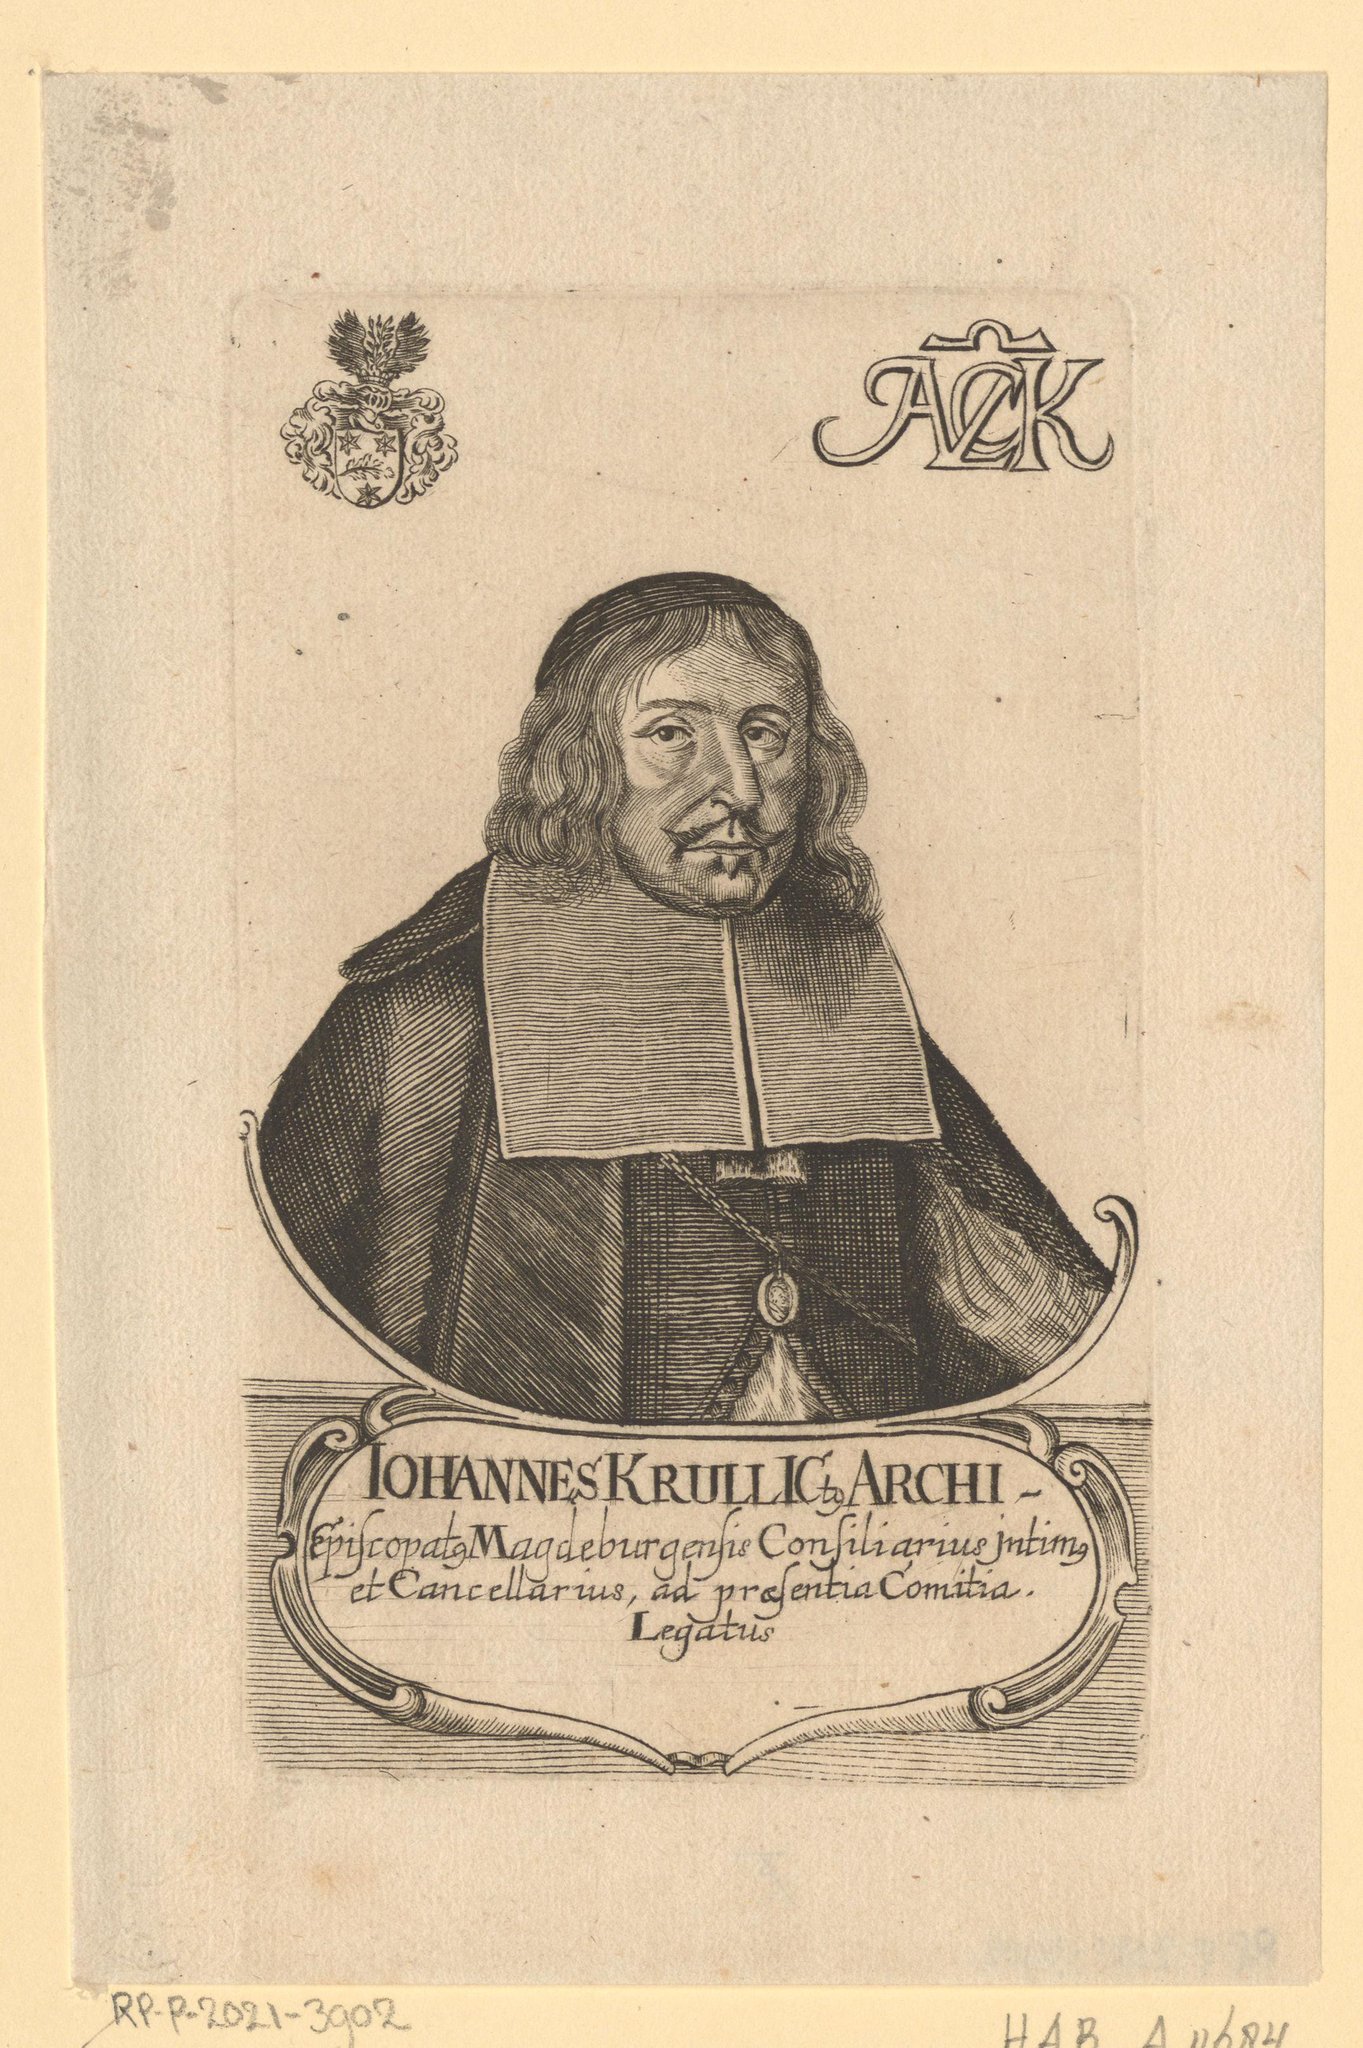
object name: print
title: Portret van Johannes Krull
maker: Anonymous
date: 1630-1699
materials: paper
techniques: engraving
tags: historical persons, armorial bearing, heraldry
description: Linksboven het portret zijn wapenschild.